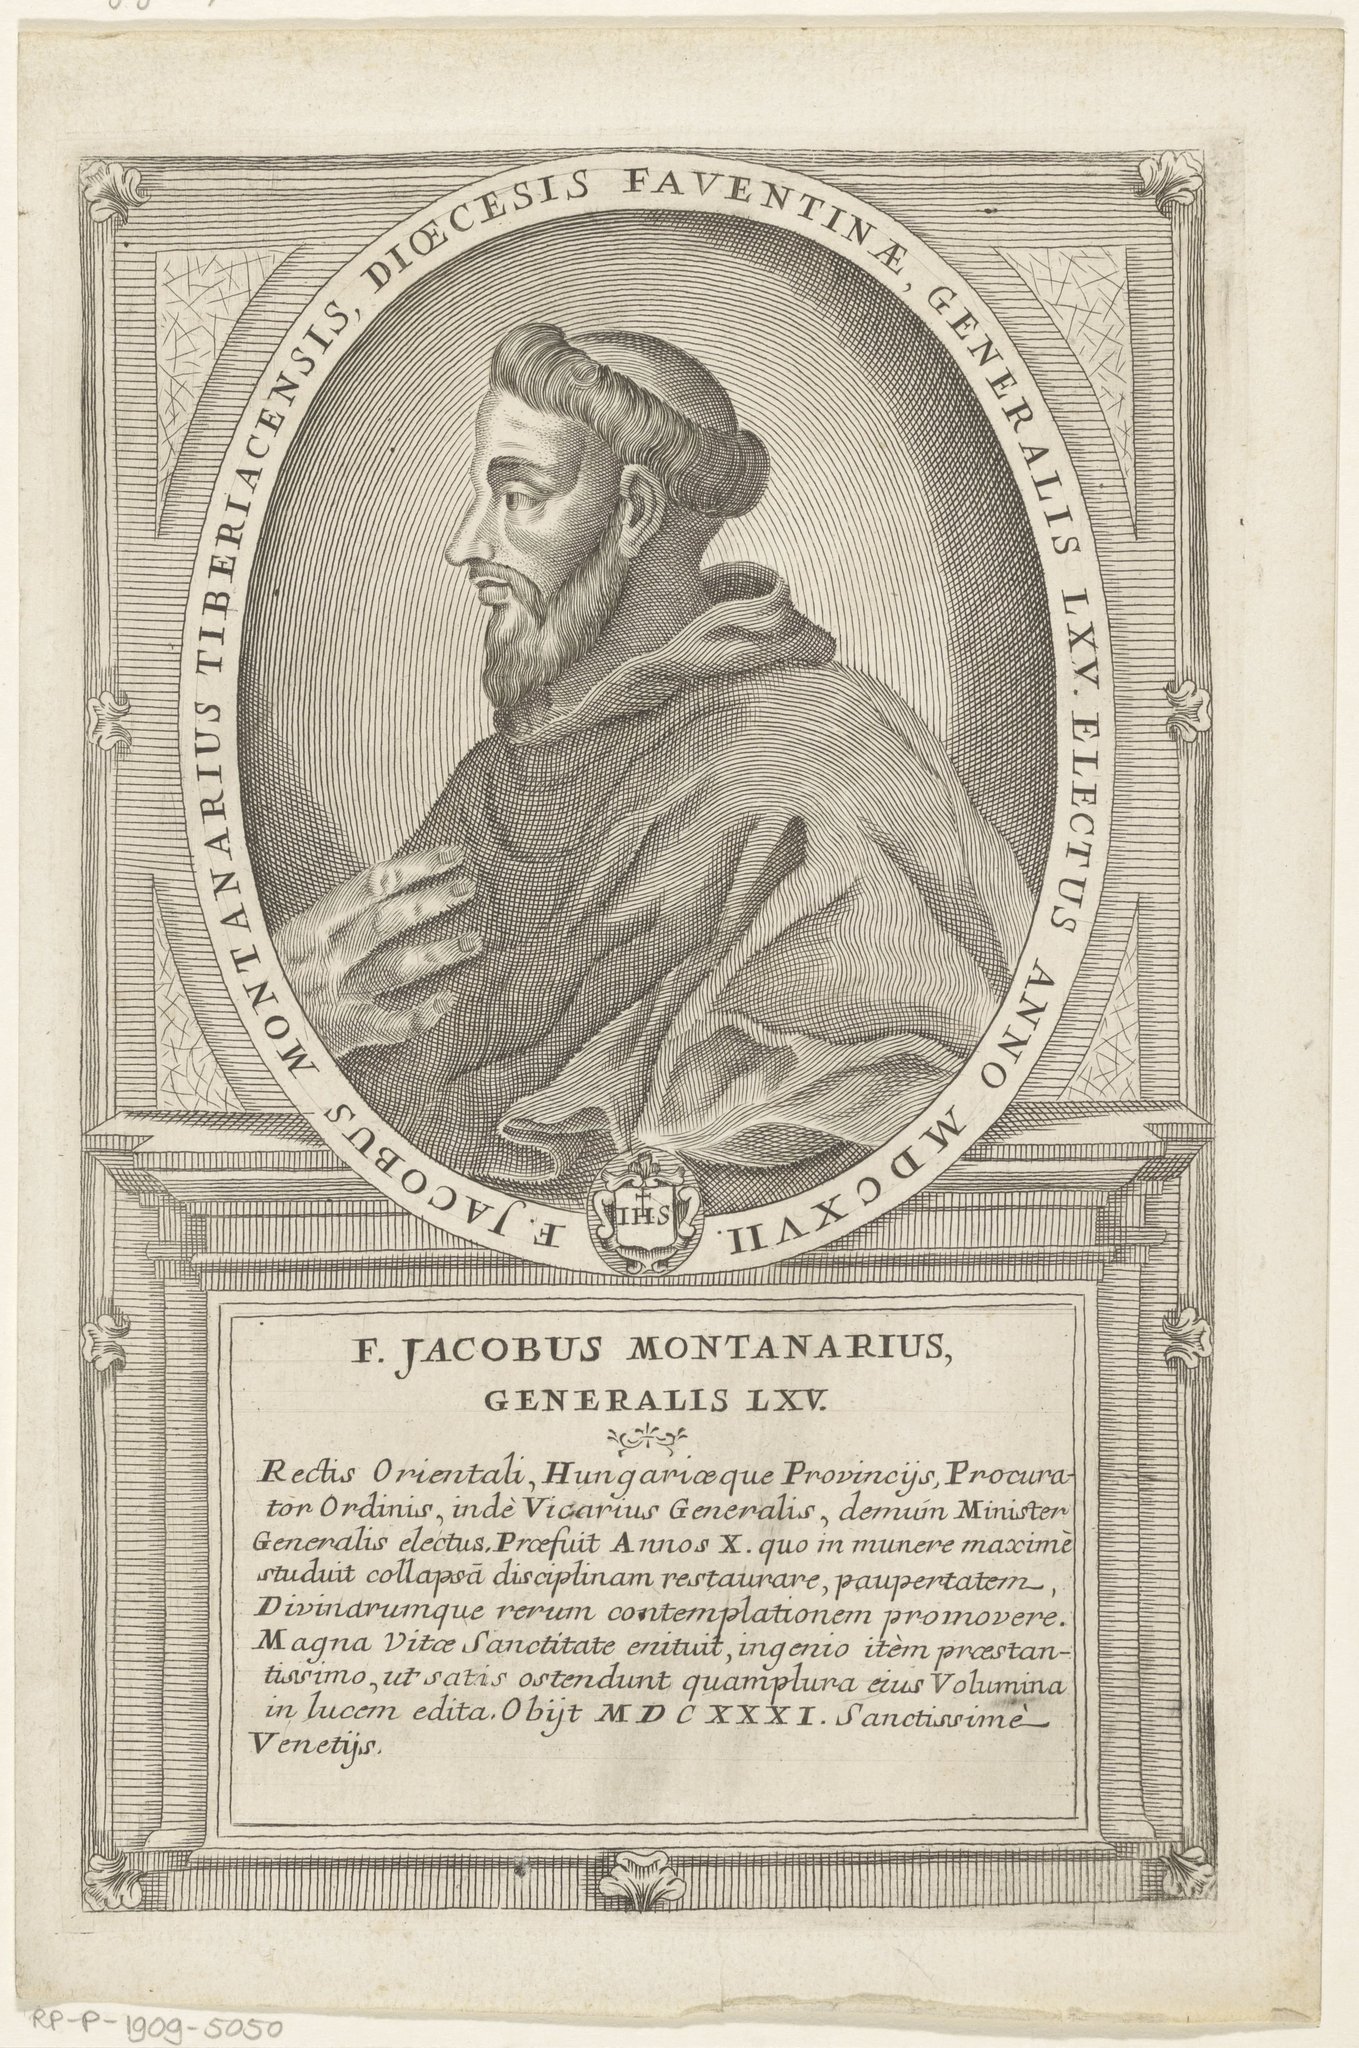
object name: print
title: Portret van Jaime Montanari, 65ste Minister Generaal van de franciscaner orde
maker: antonio luciani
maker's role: print maker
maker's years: 1700-1738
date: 1710-1738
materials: paper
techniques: engraving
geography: italy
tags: clergyman, historical persons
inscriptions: collector's mark: Lugt 2228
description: Deze prent maakt deel uit van een groep van 60 portretten.